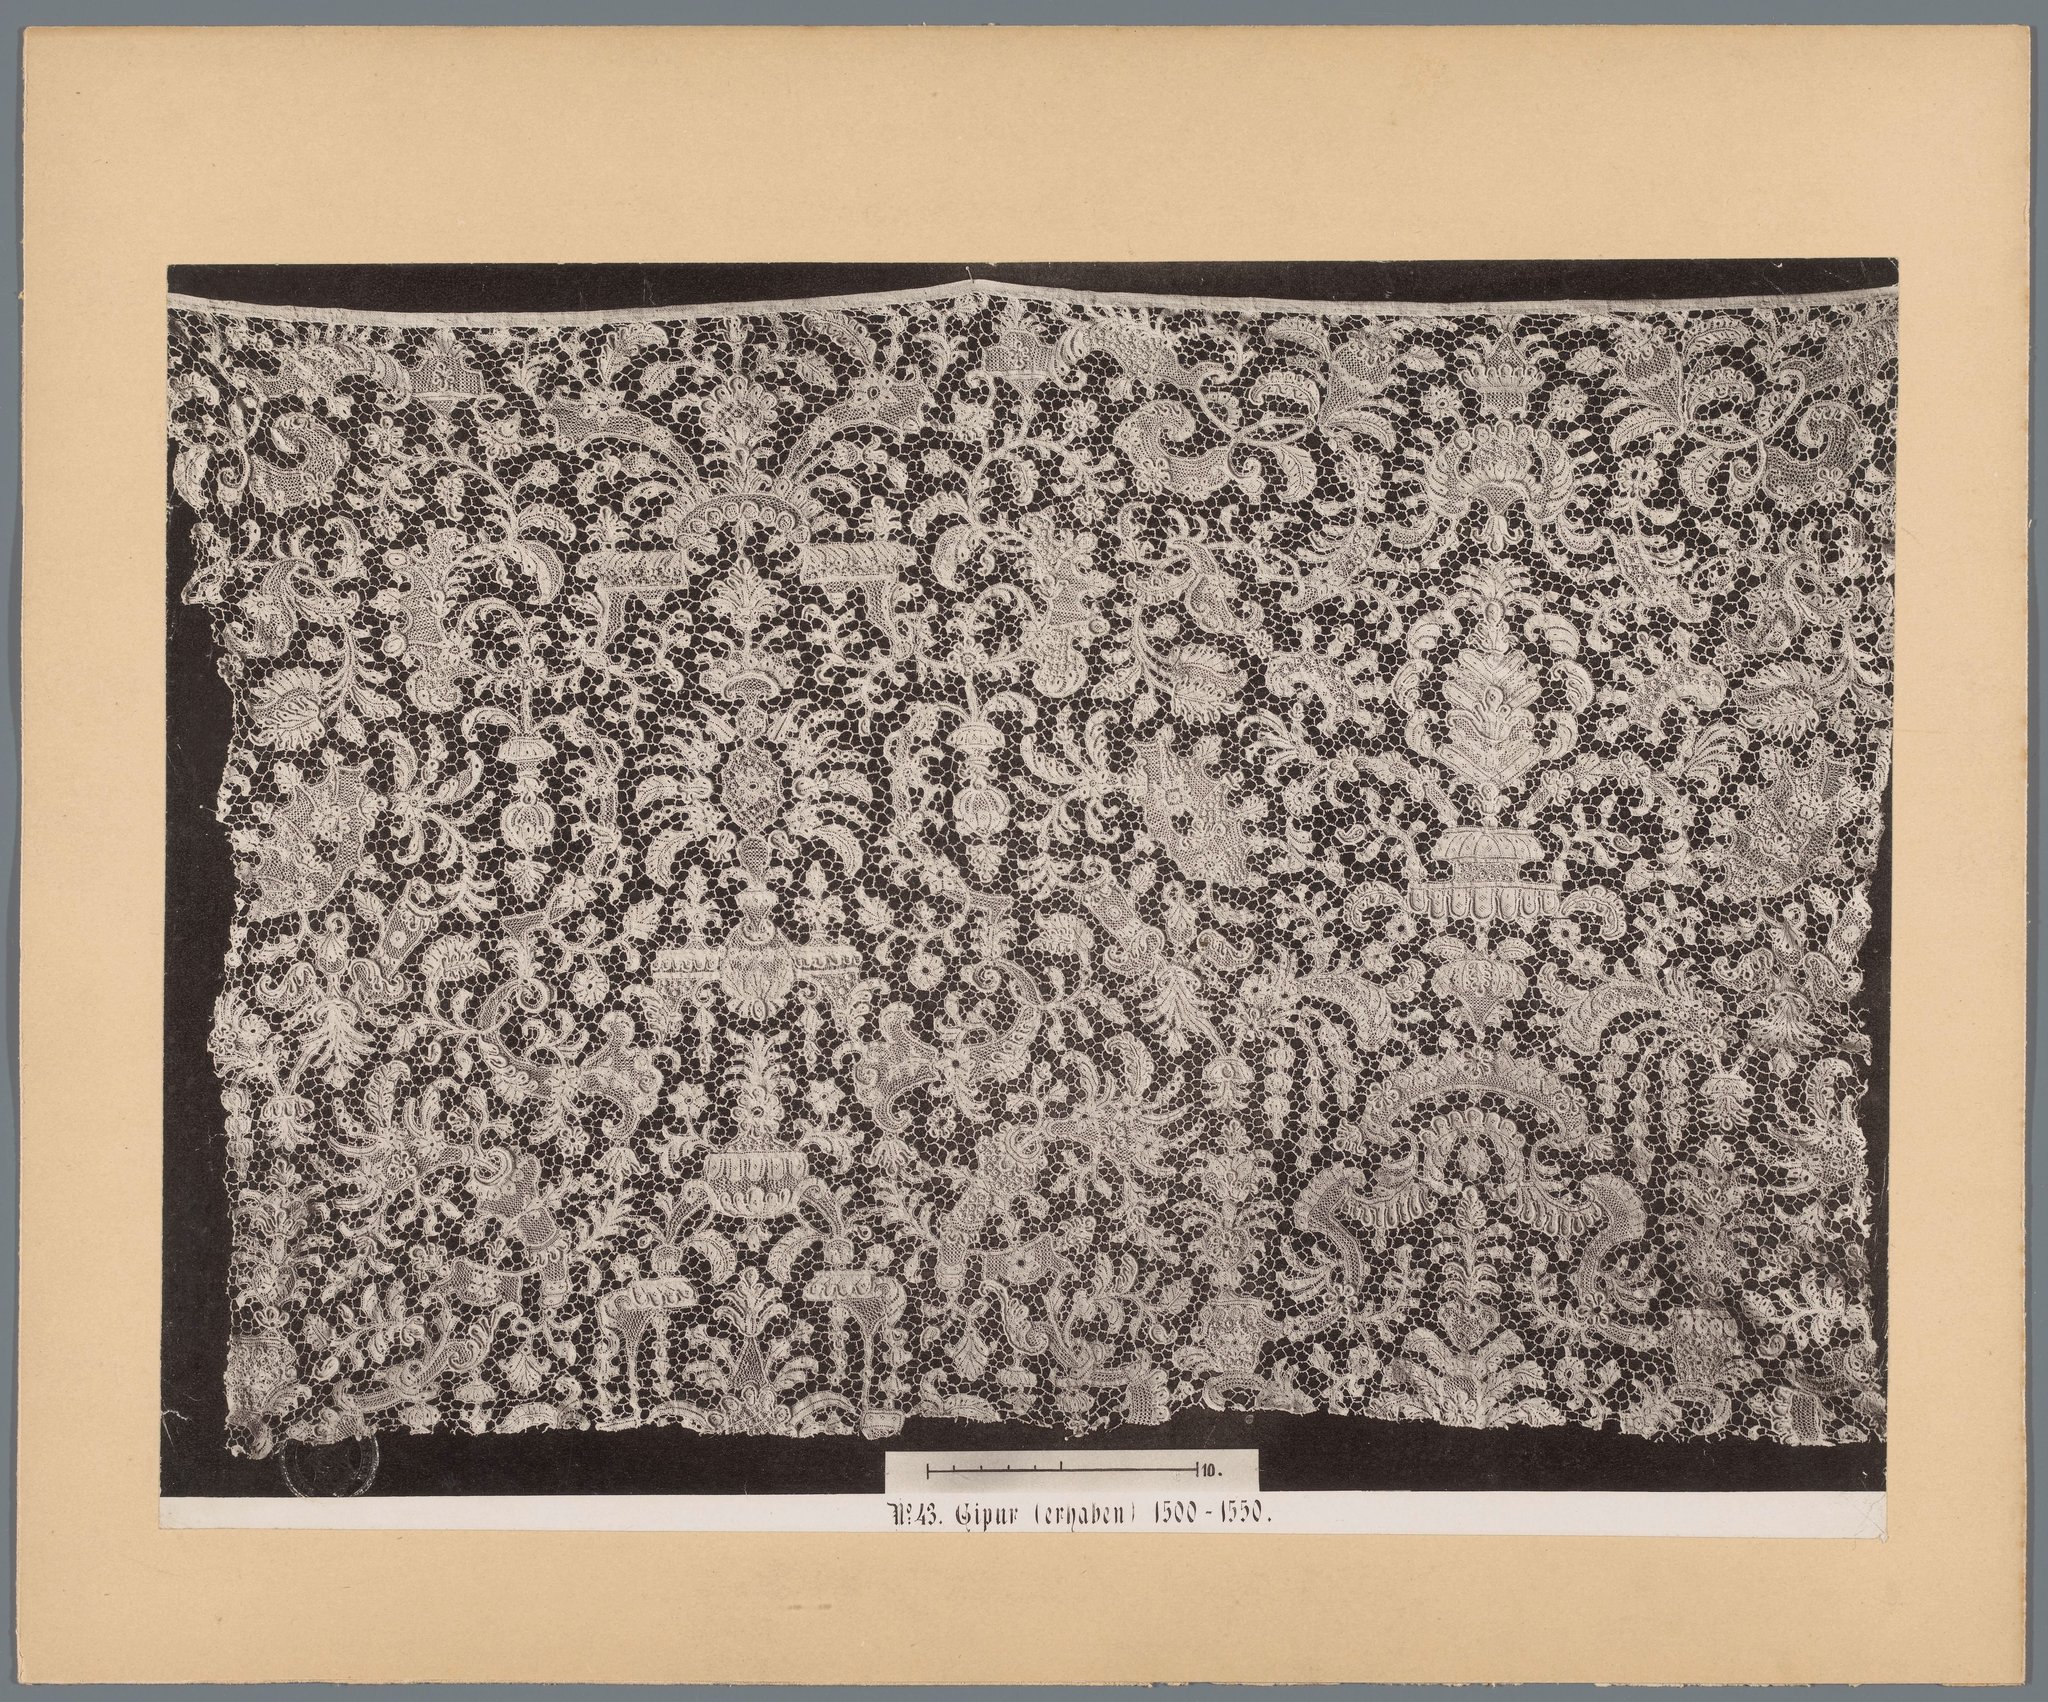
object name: photograph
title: Lap van guipurekant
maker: Anonymous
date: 1875-1900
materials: cardboard, paper, ink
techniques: photograph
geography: europe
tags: lace, europe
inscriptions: number: ‘No: 43.’, inscription: ‘Bayerisch National Museum’, collector's mark: Lugt 3937